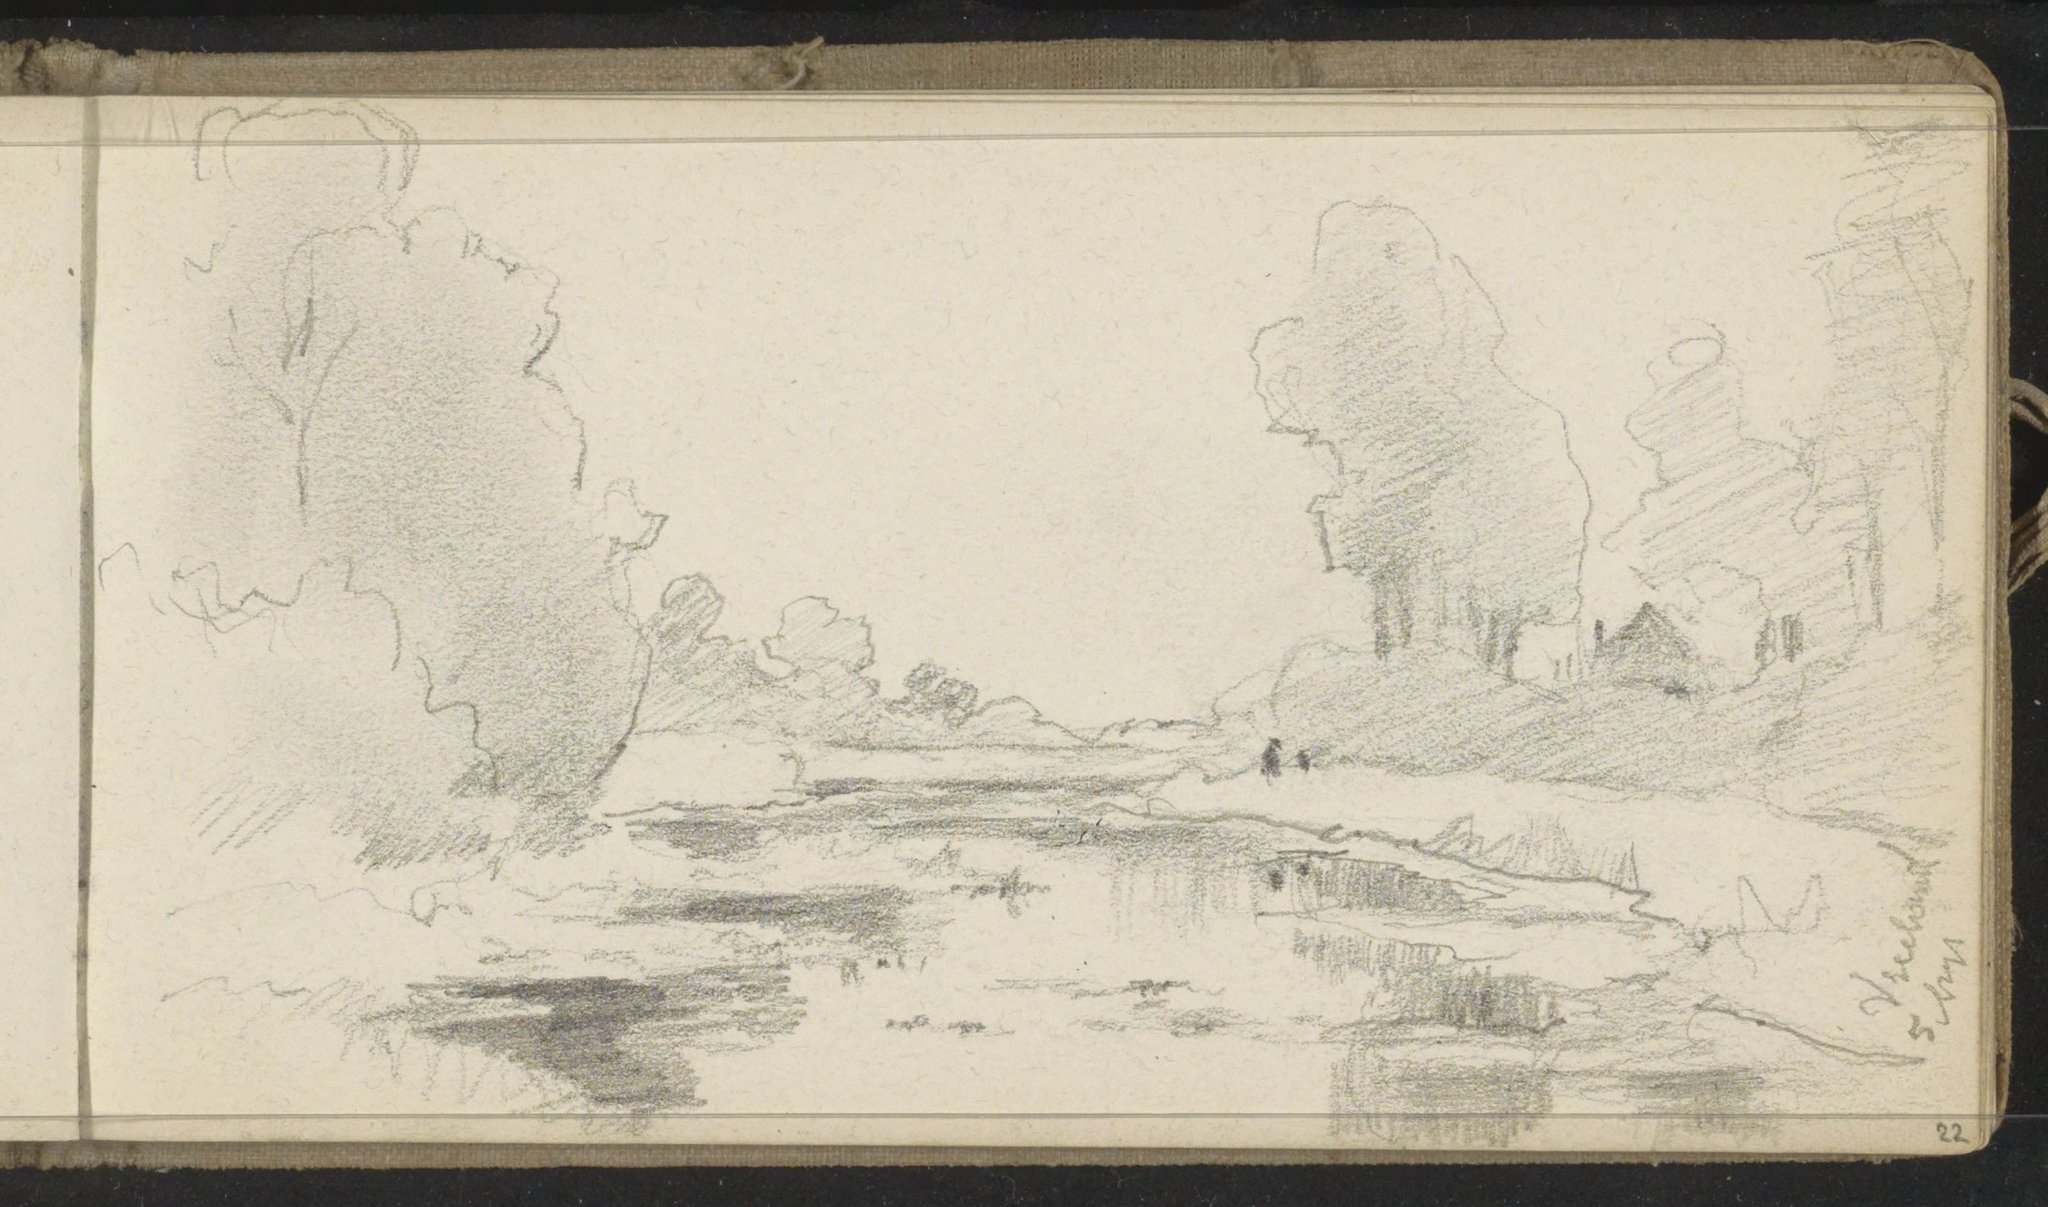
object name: sketchbook leaf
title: Vecht bij Vreeland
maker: willem cornelis rip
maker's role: draughtsman, painter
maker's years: 1856-1922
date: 1808-1895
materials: paper, pencil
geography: vreeland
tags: river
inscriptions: date and inscription: ‘Vreeland/ 5 Aug’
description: Blad 22 recto uit een schetsboek met 39 bladen.